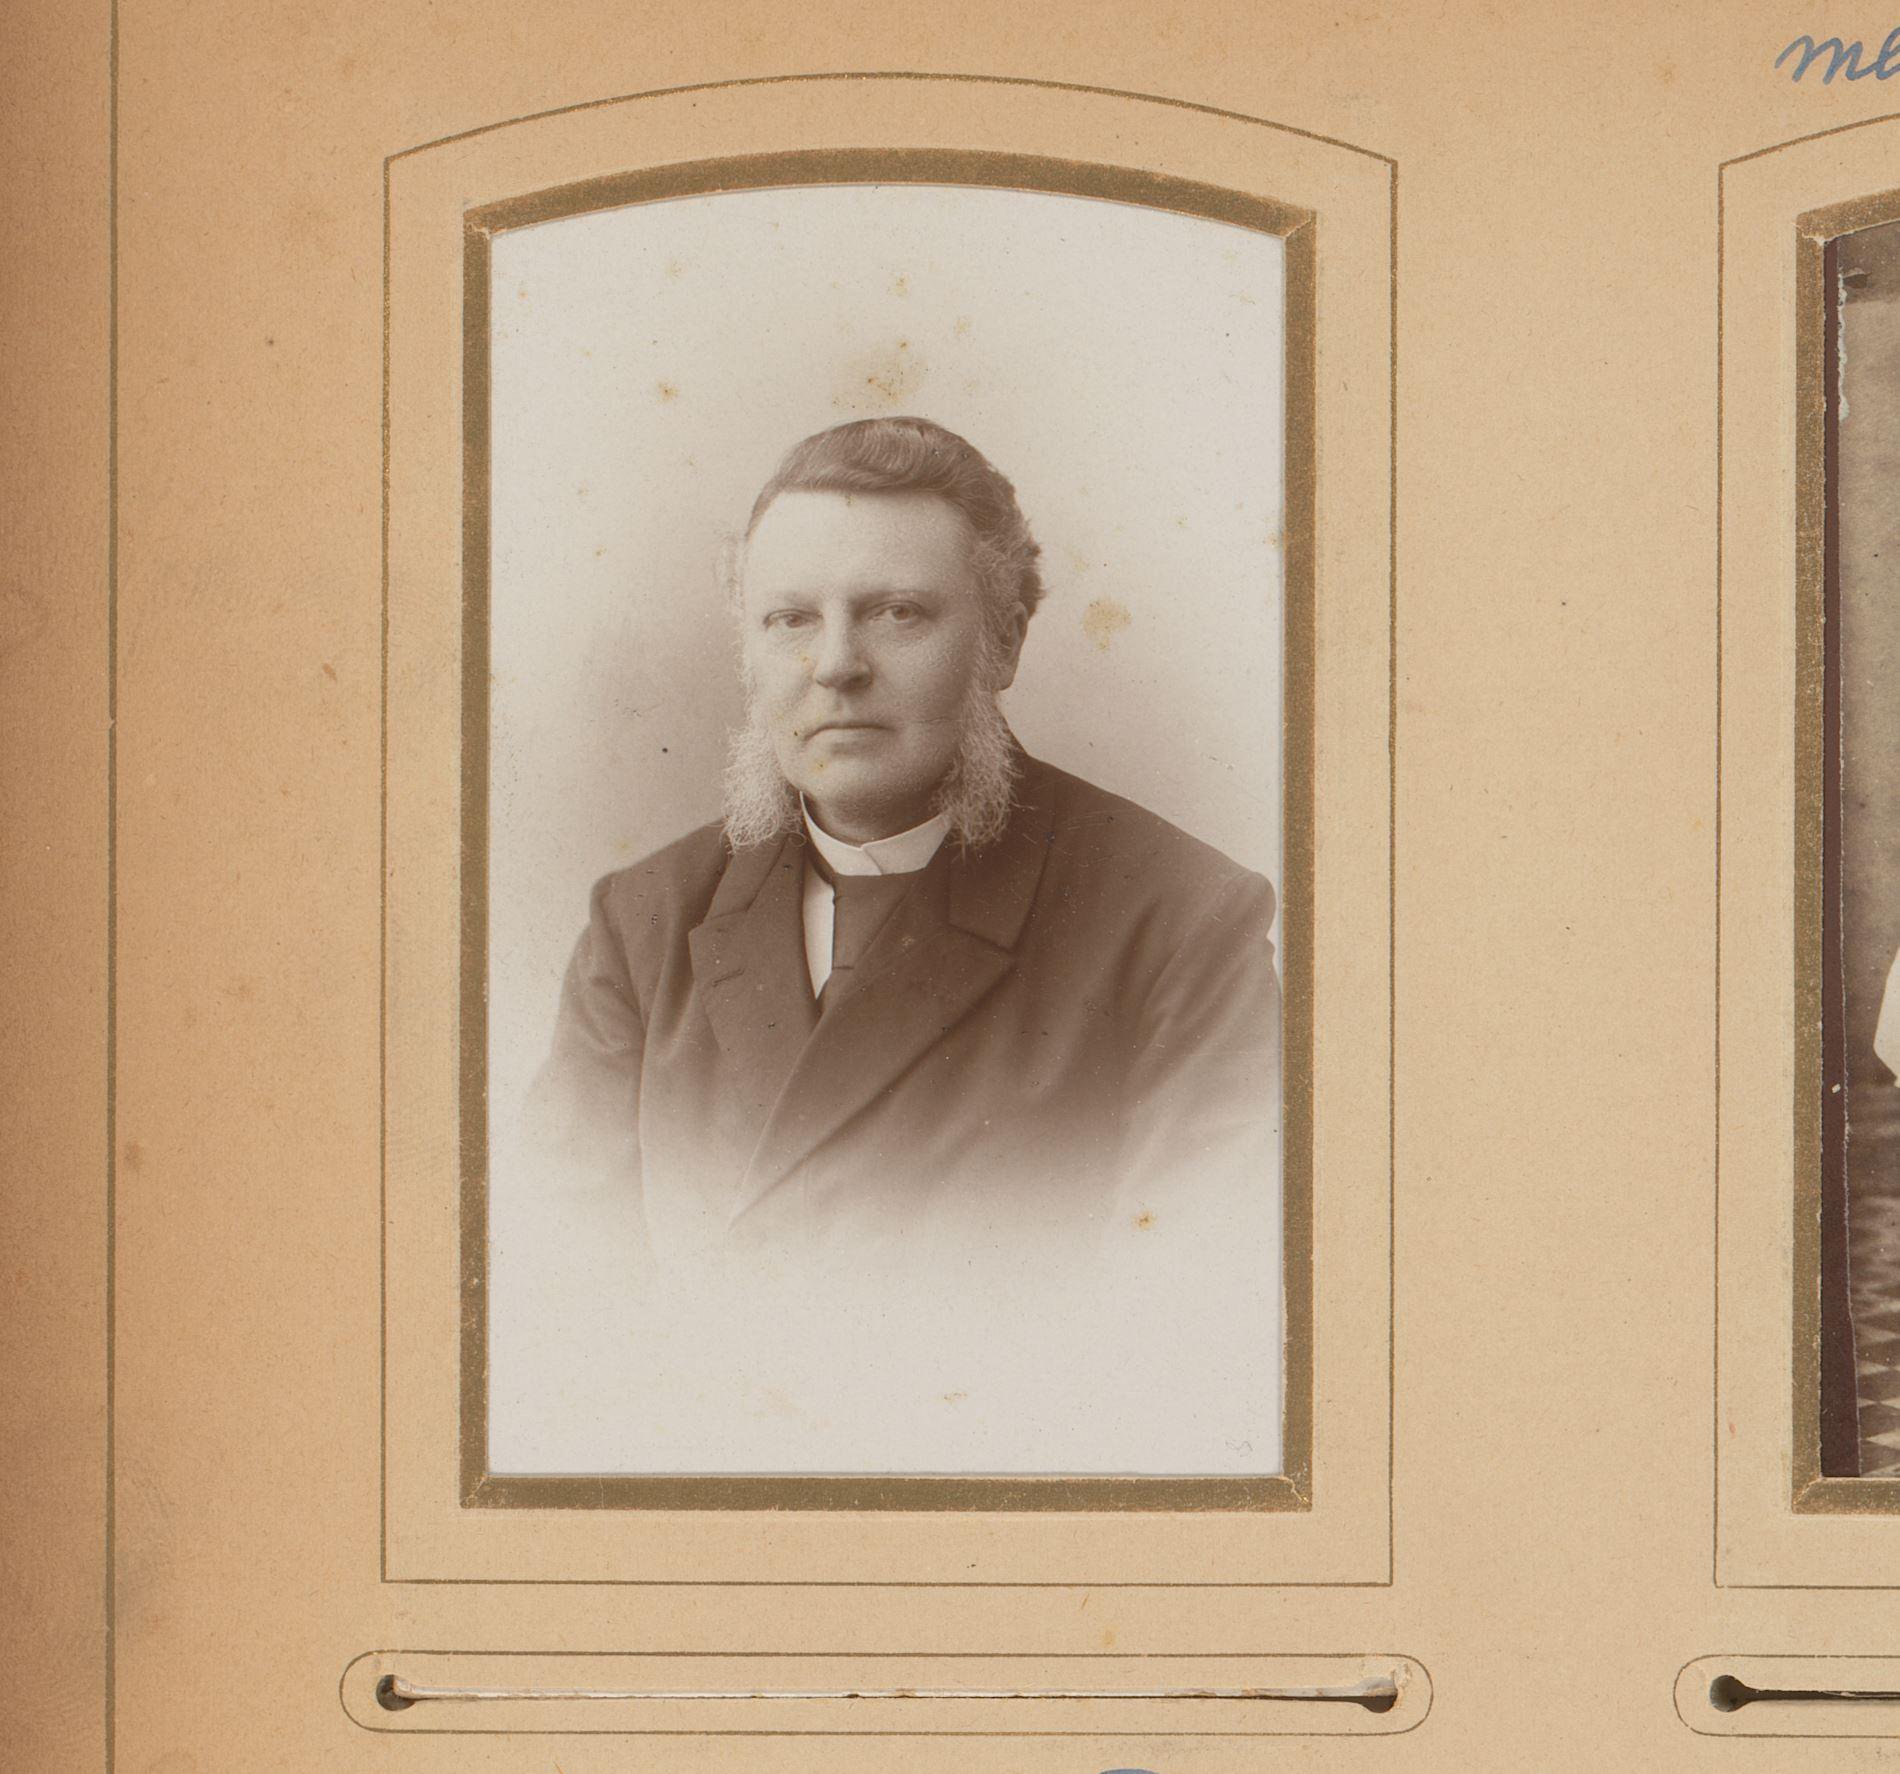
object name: photograph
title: Portret van een man met bakkebaarden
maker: Anonymous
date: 1880-1920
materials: cardboard, photographic support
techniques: collodion silver print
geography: netherlands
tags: sideburns, historical persons